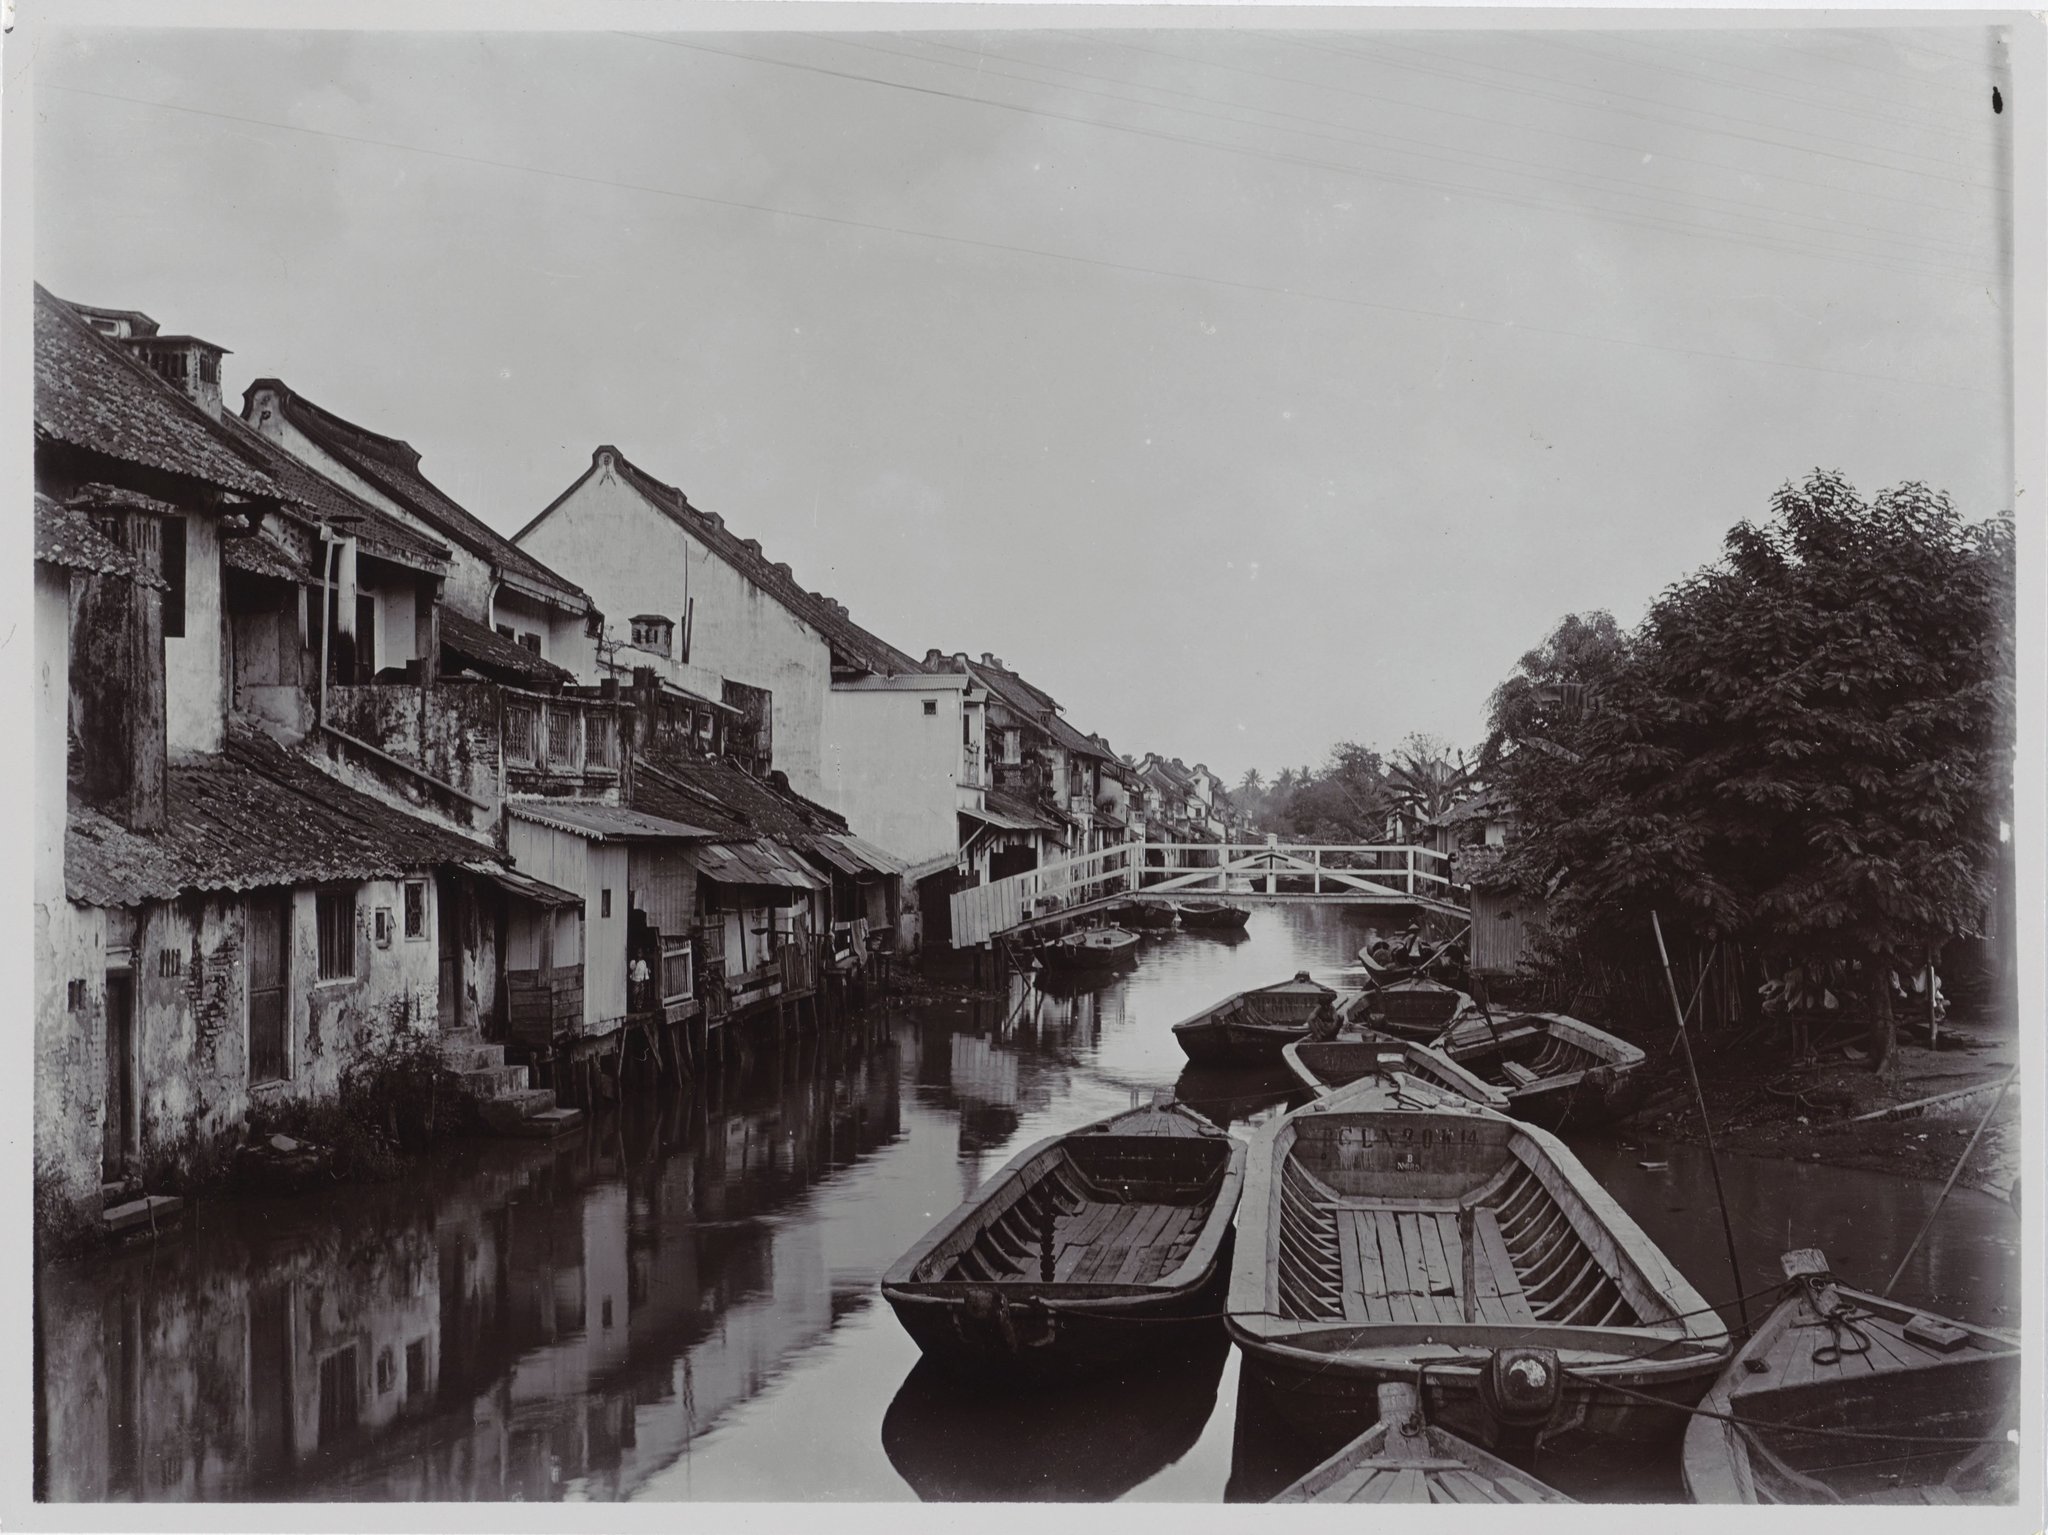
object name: photograph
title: Zicht langs een water op Java met aan weerszijden woningen.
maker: johanna hermina marmelstein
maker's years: 1897-1990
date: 1900-1915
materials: paper, photographic support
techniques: albumen print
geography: jakarta